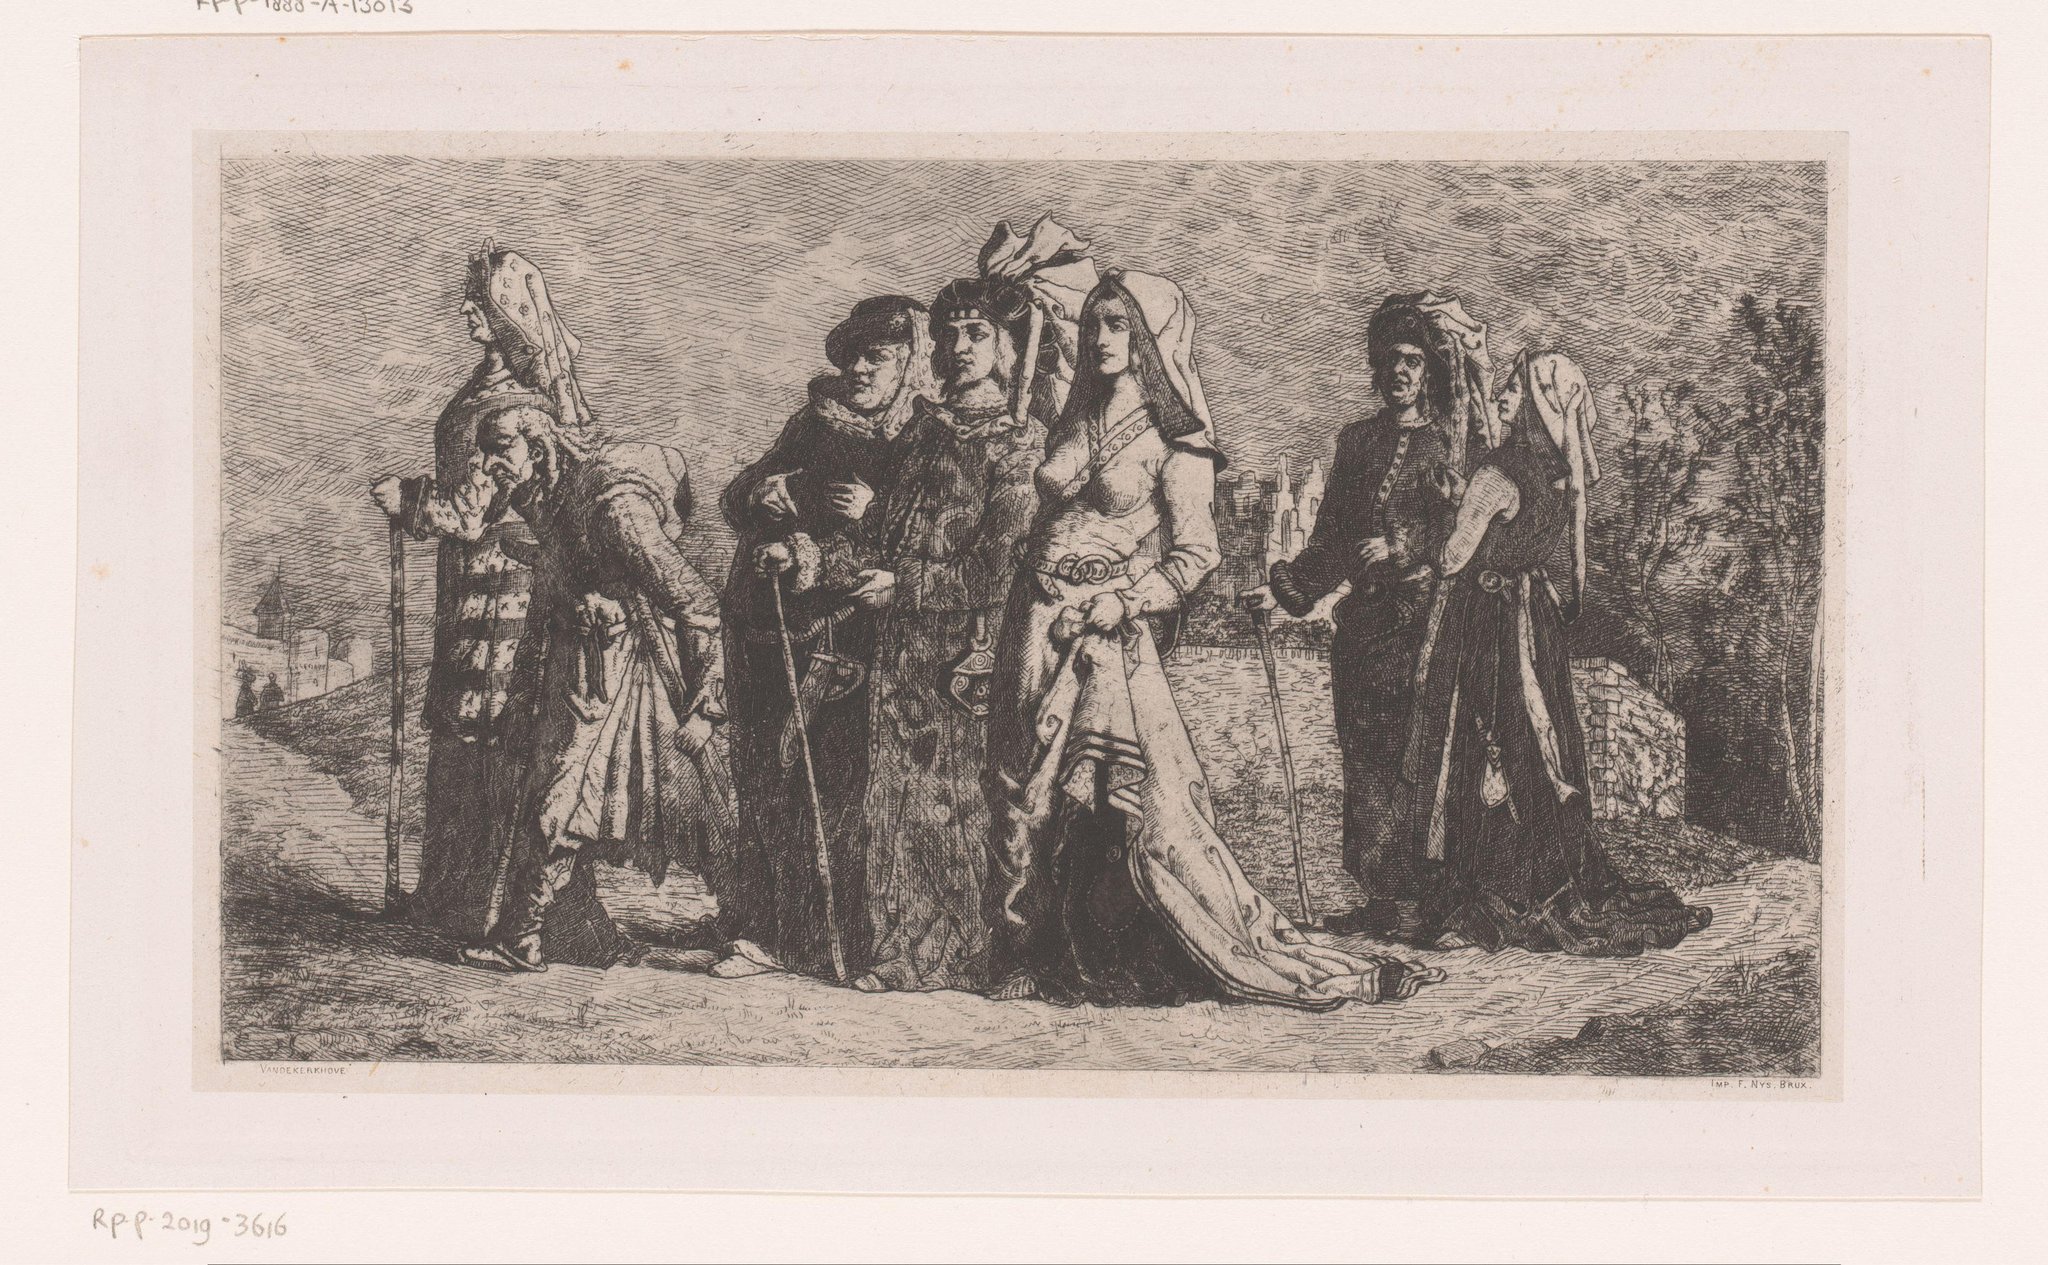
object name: print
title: Drie bedelaren in een landschap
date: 1840-1870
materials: paper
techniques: etching, intaglio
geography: brussels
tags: beggar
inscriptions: collector's mark: Lugt 2228